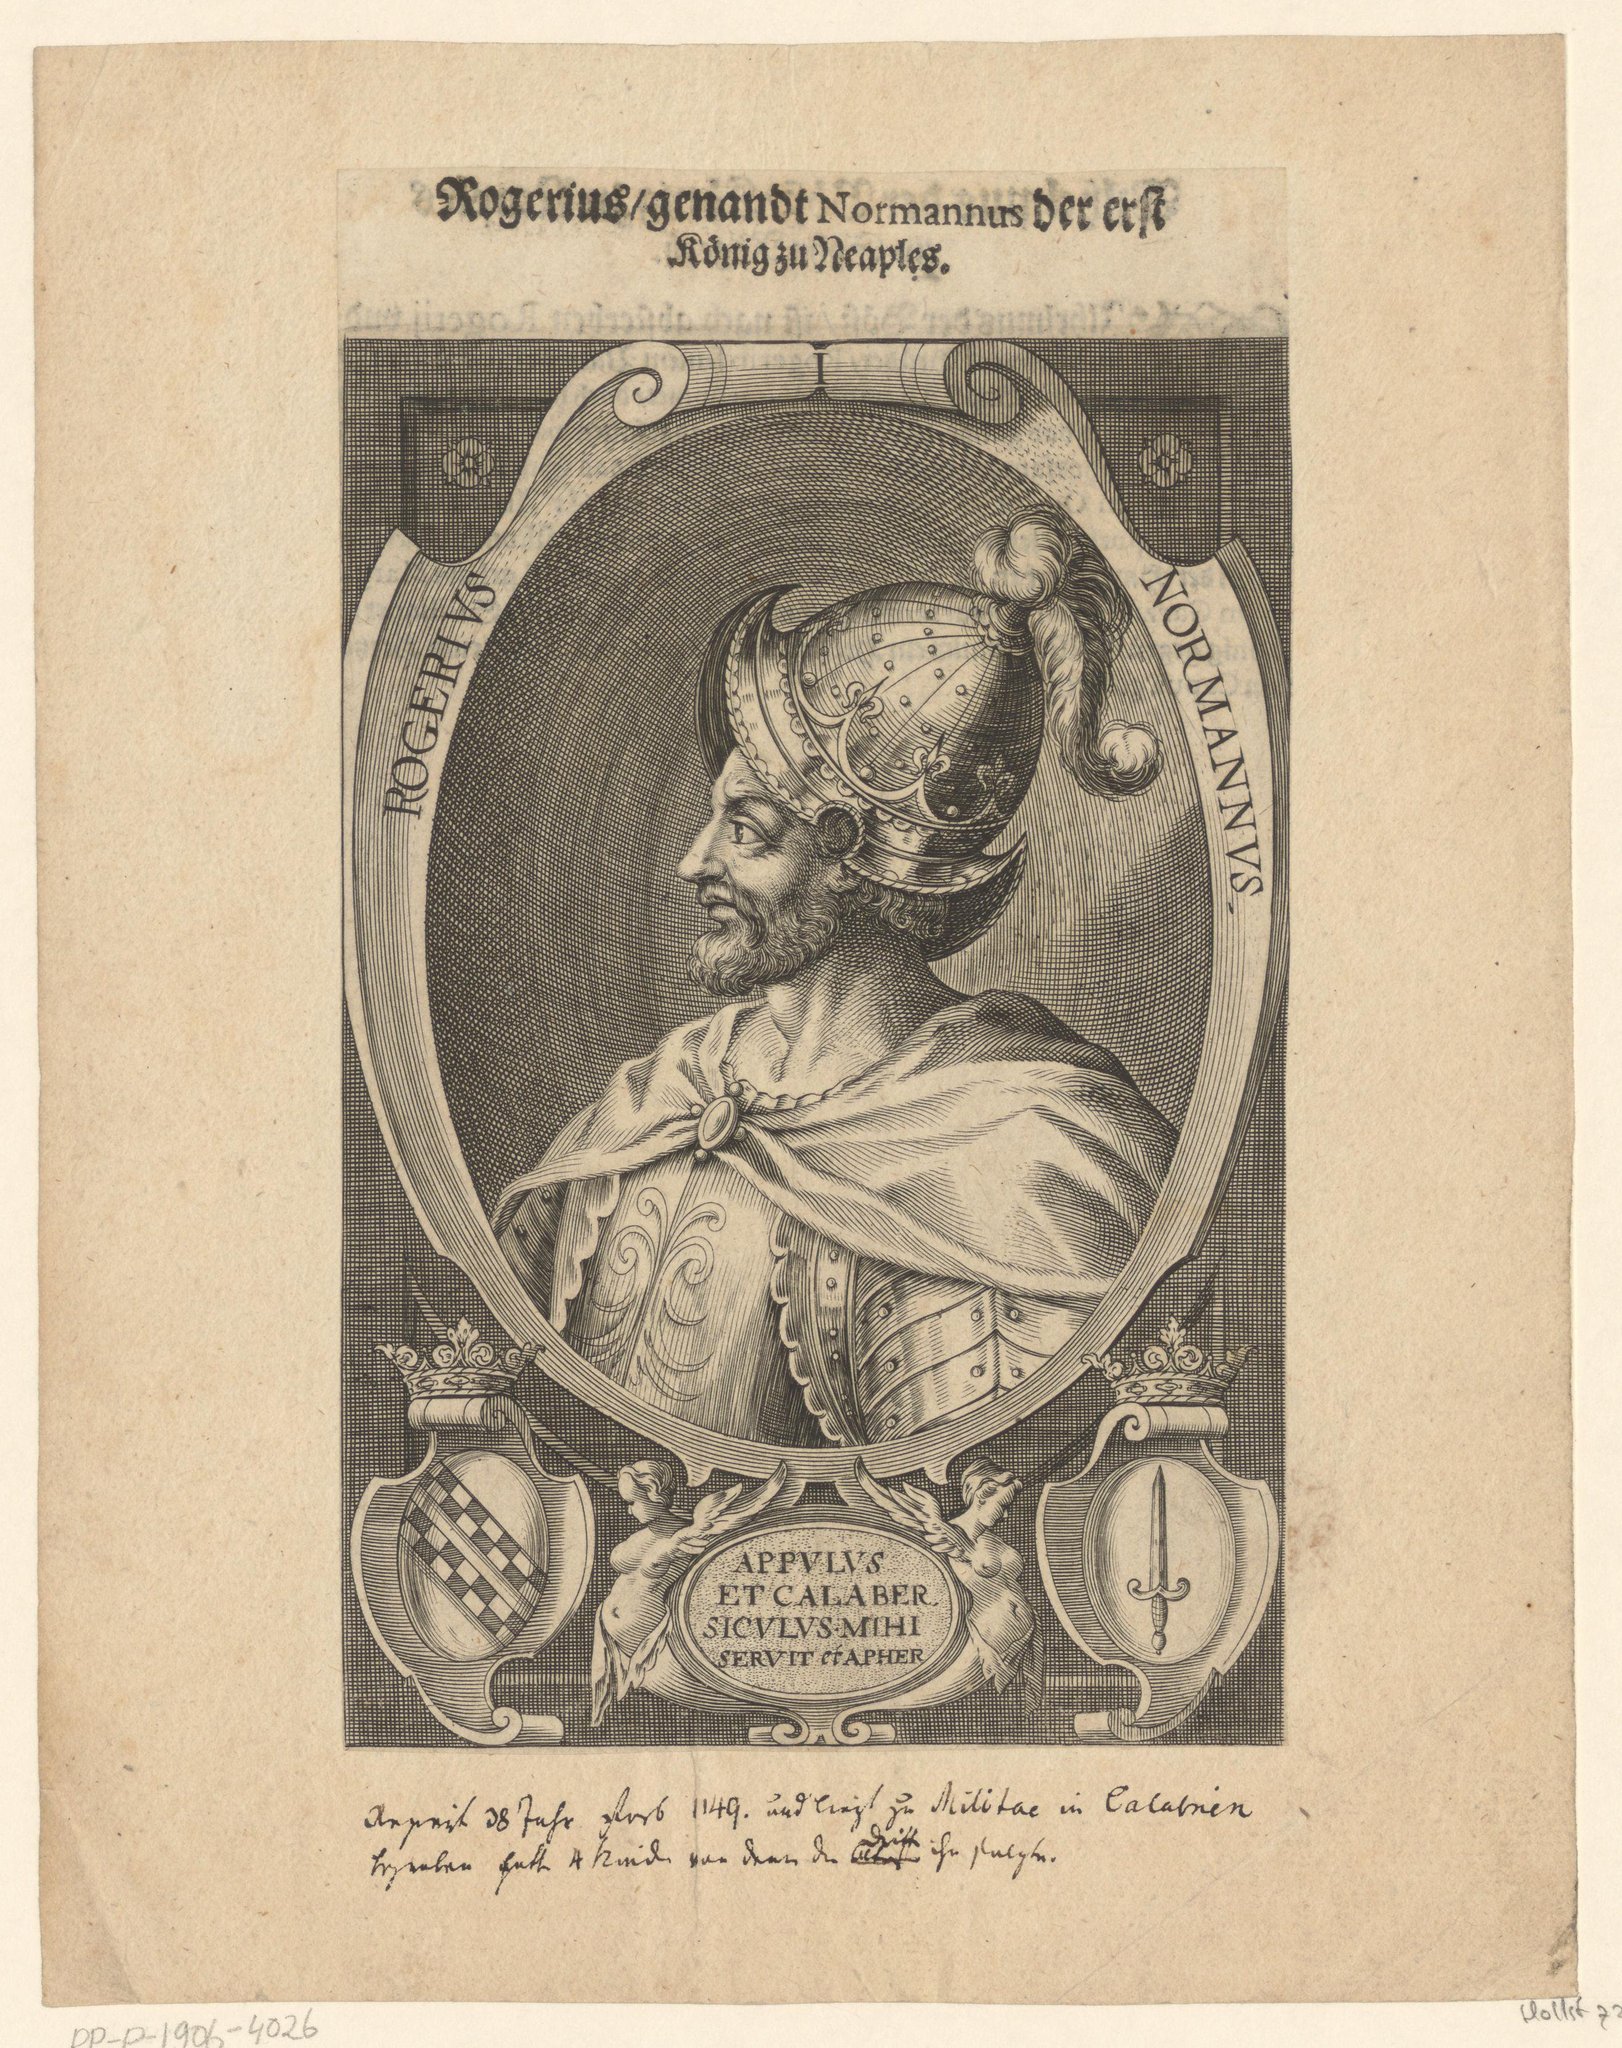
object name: print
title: Portret van Rogier II van Sicilië, koning van Napels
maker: lucas kilian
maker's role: draughtsman, print maker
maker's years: 1579-1637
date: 1589-1624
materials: paper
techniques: engraving, etching, letterpress printing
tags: commander-in-chief, general, marshal, historical persons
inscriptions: collector's mark: Lugt 2228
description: Deze prent is gebruikt in: Mazzella, Scipione, Kilian, Lucas en Custos, Dominicus. Der Neapolitanische Koenige Leben und Bildnisse (...). Augsburg: Lucas Kilian, 1624.